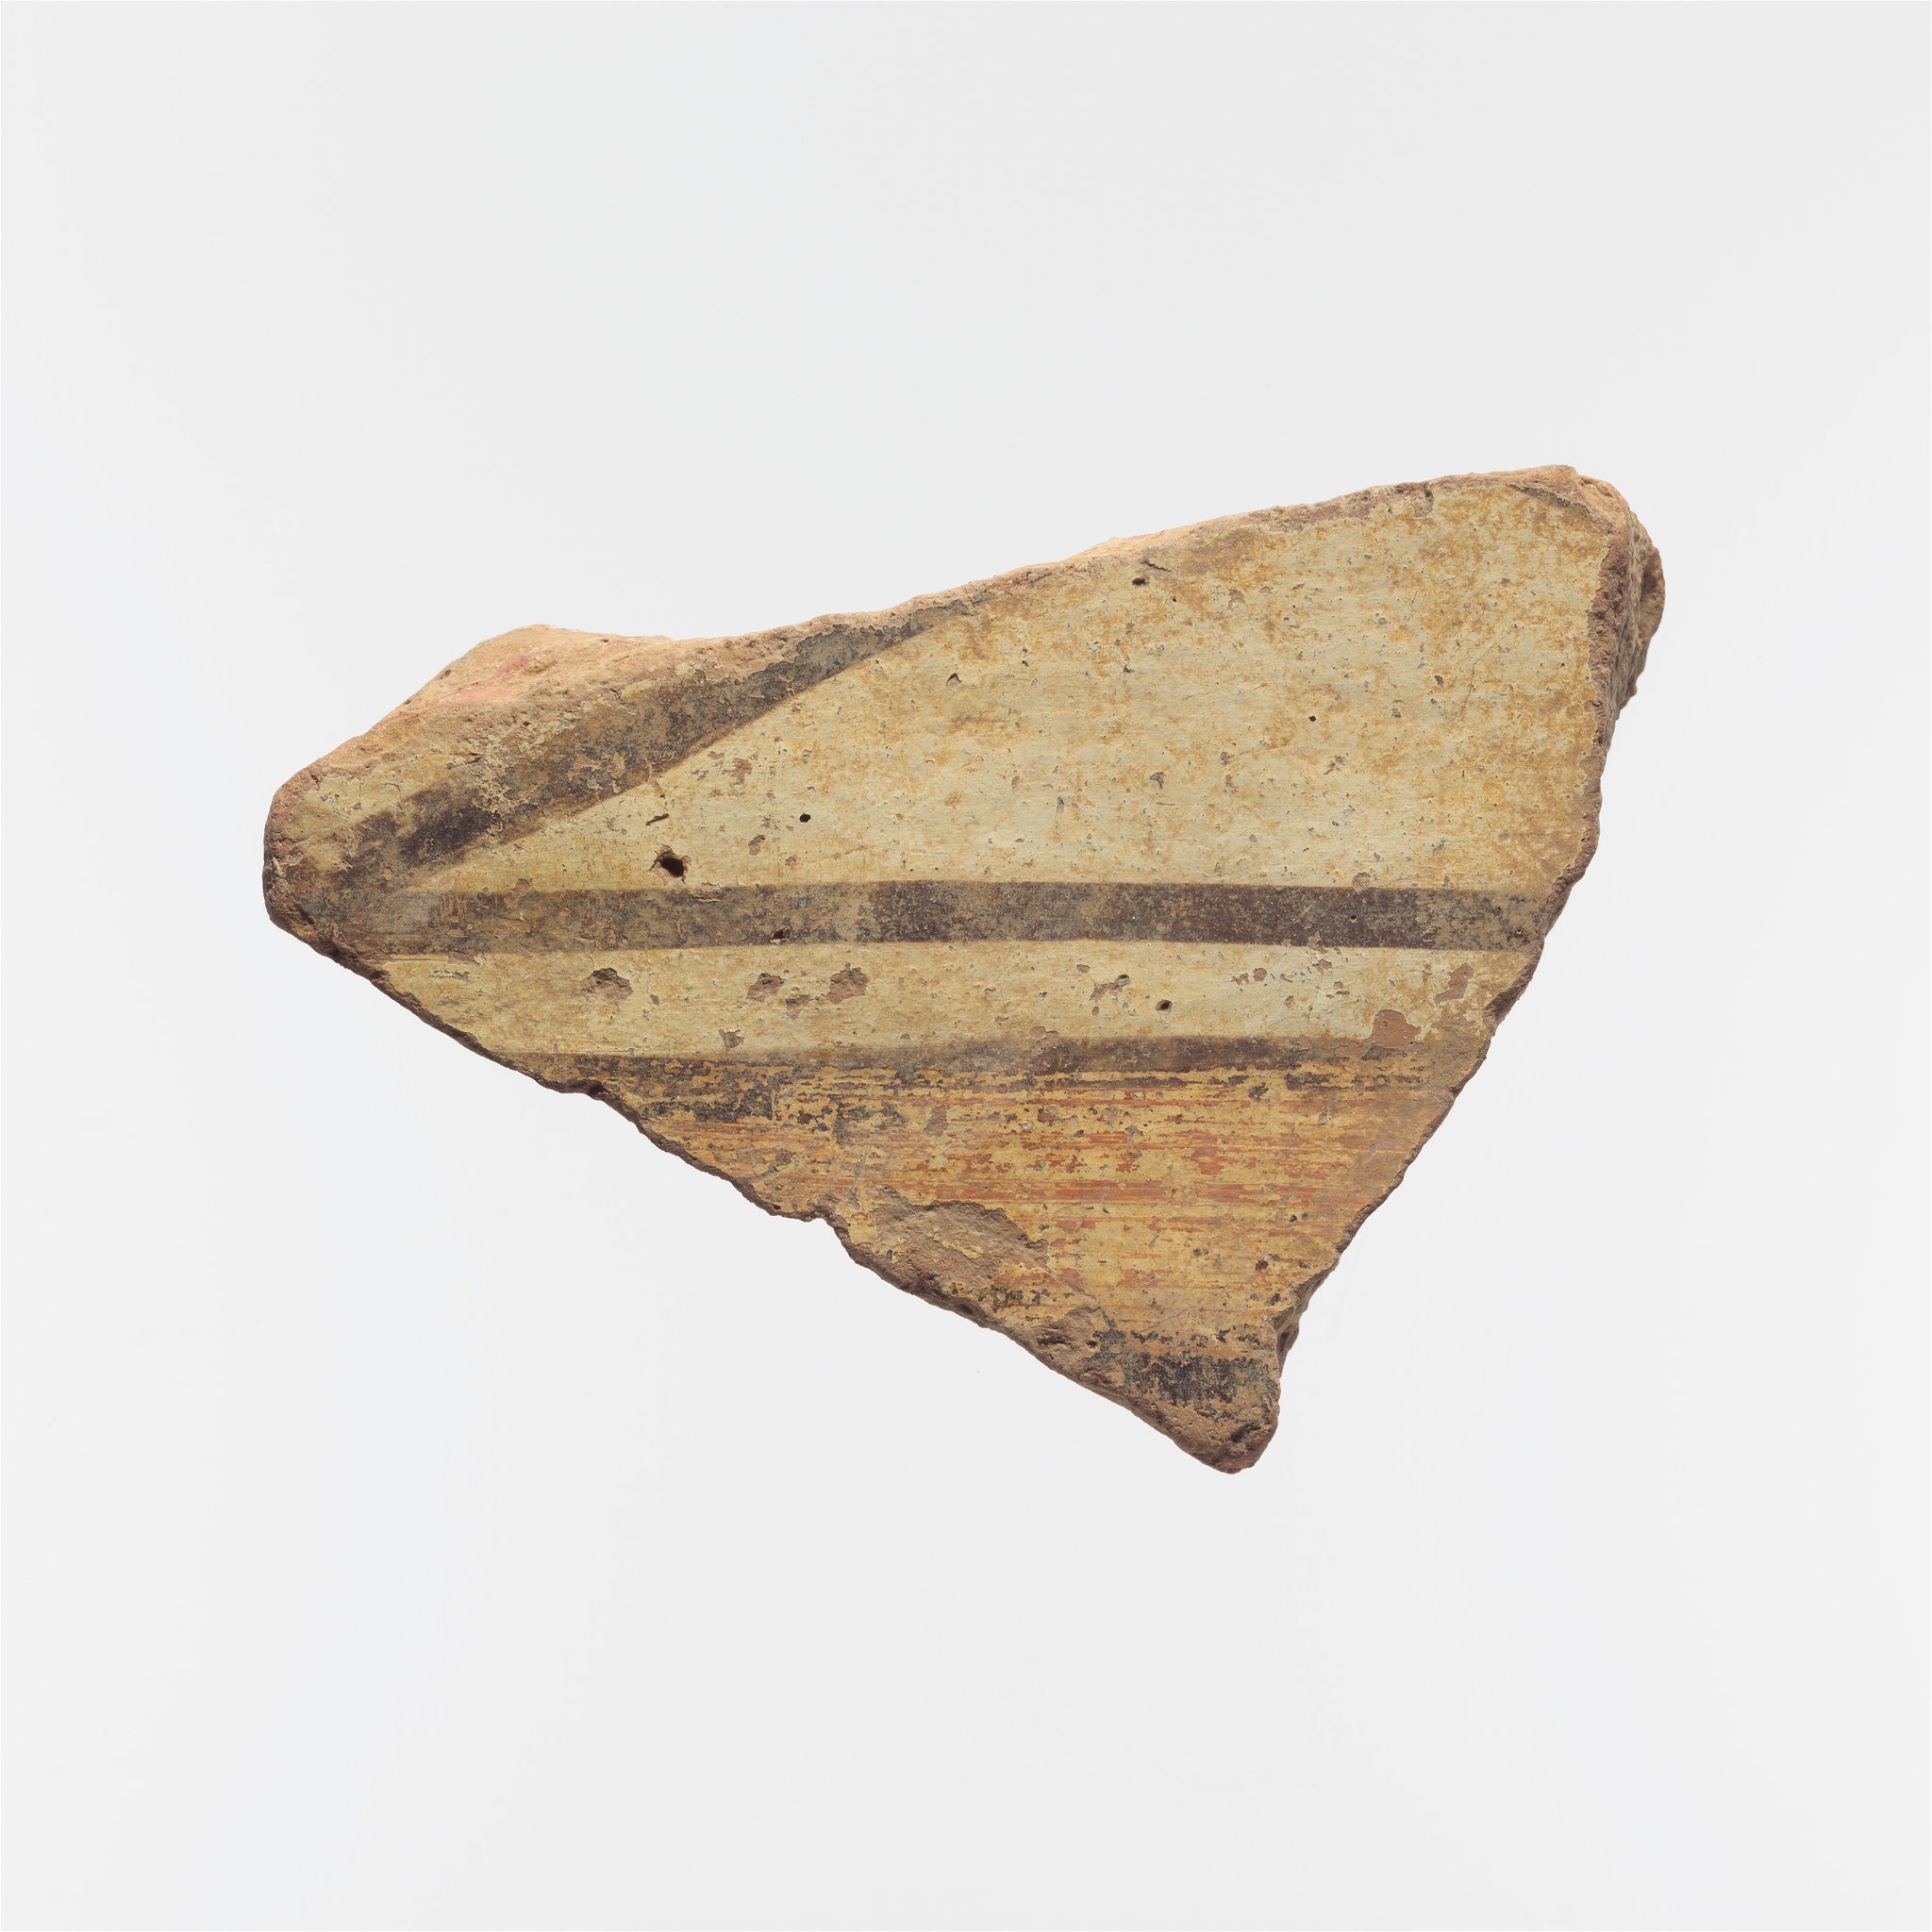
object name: tile fragment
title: Fragment of a terracotta architectural tile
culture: lydian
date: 600-501 BCE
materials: terracotta